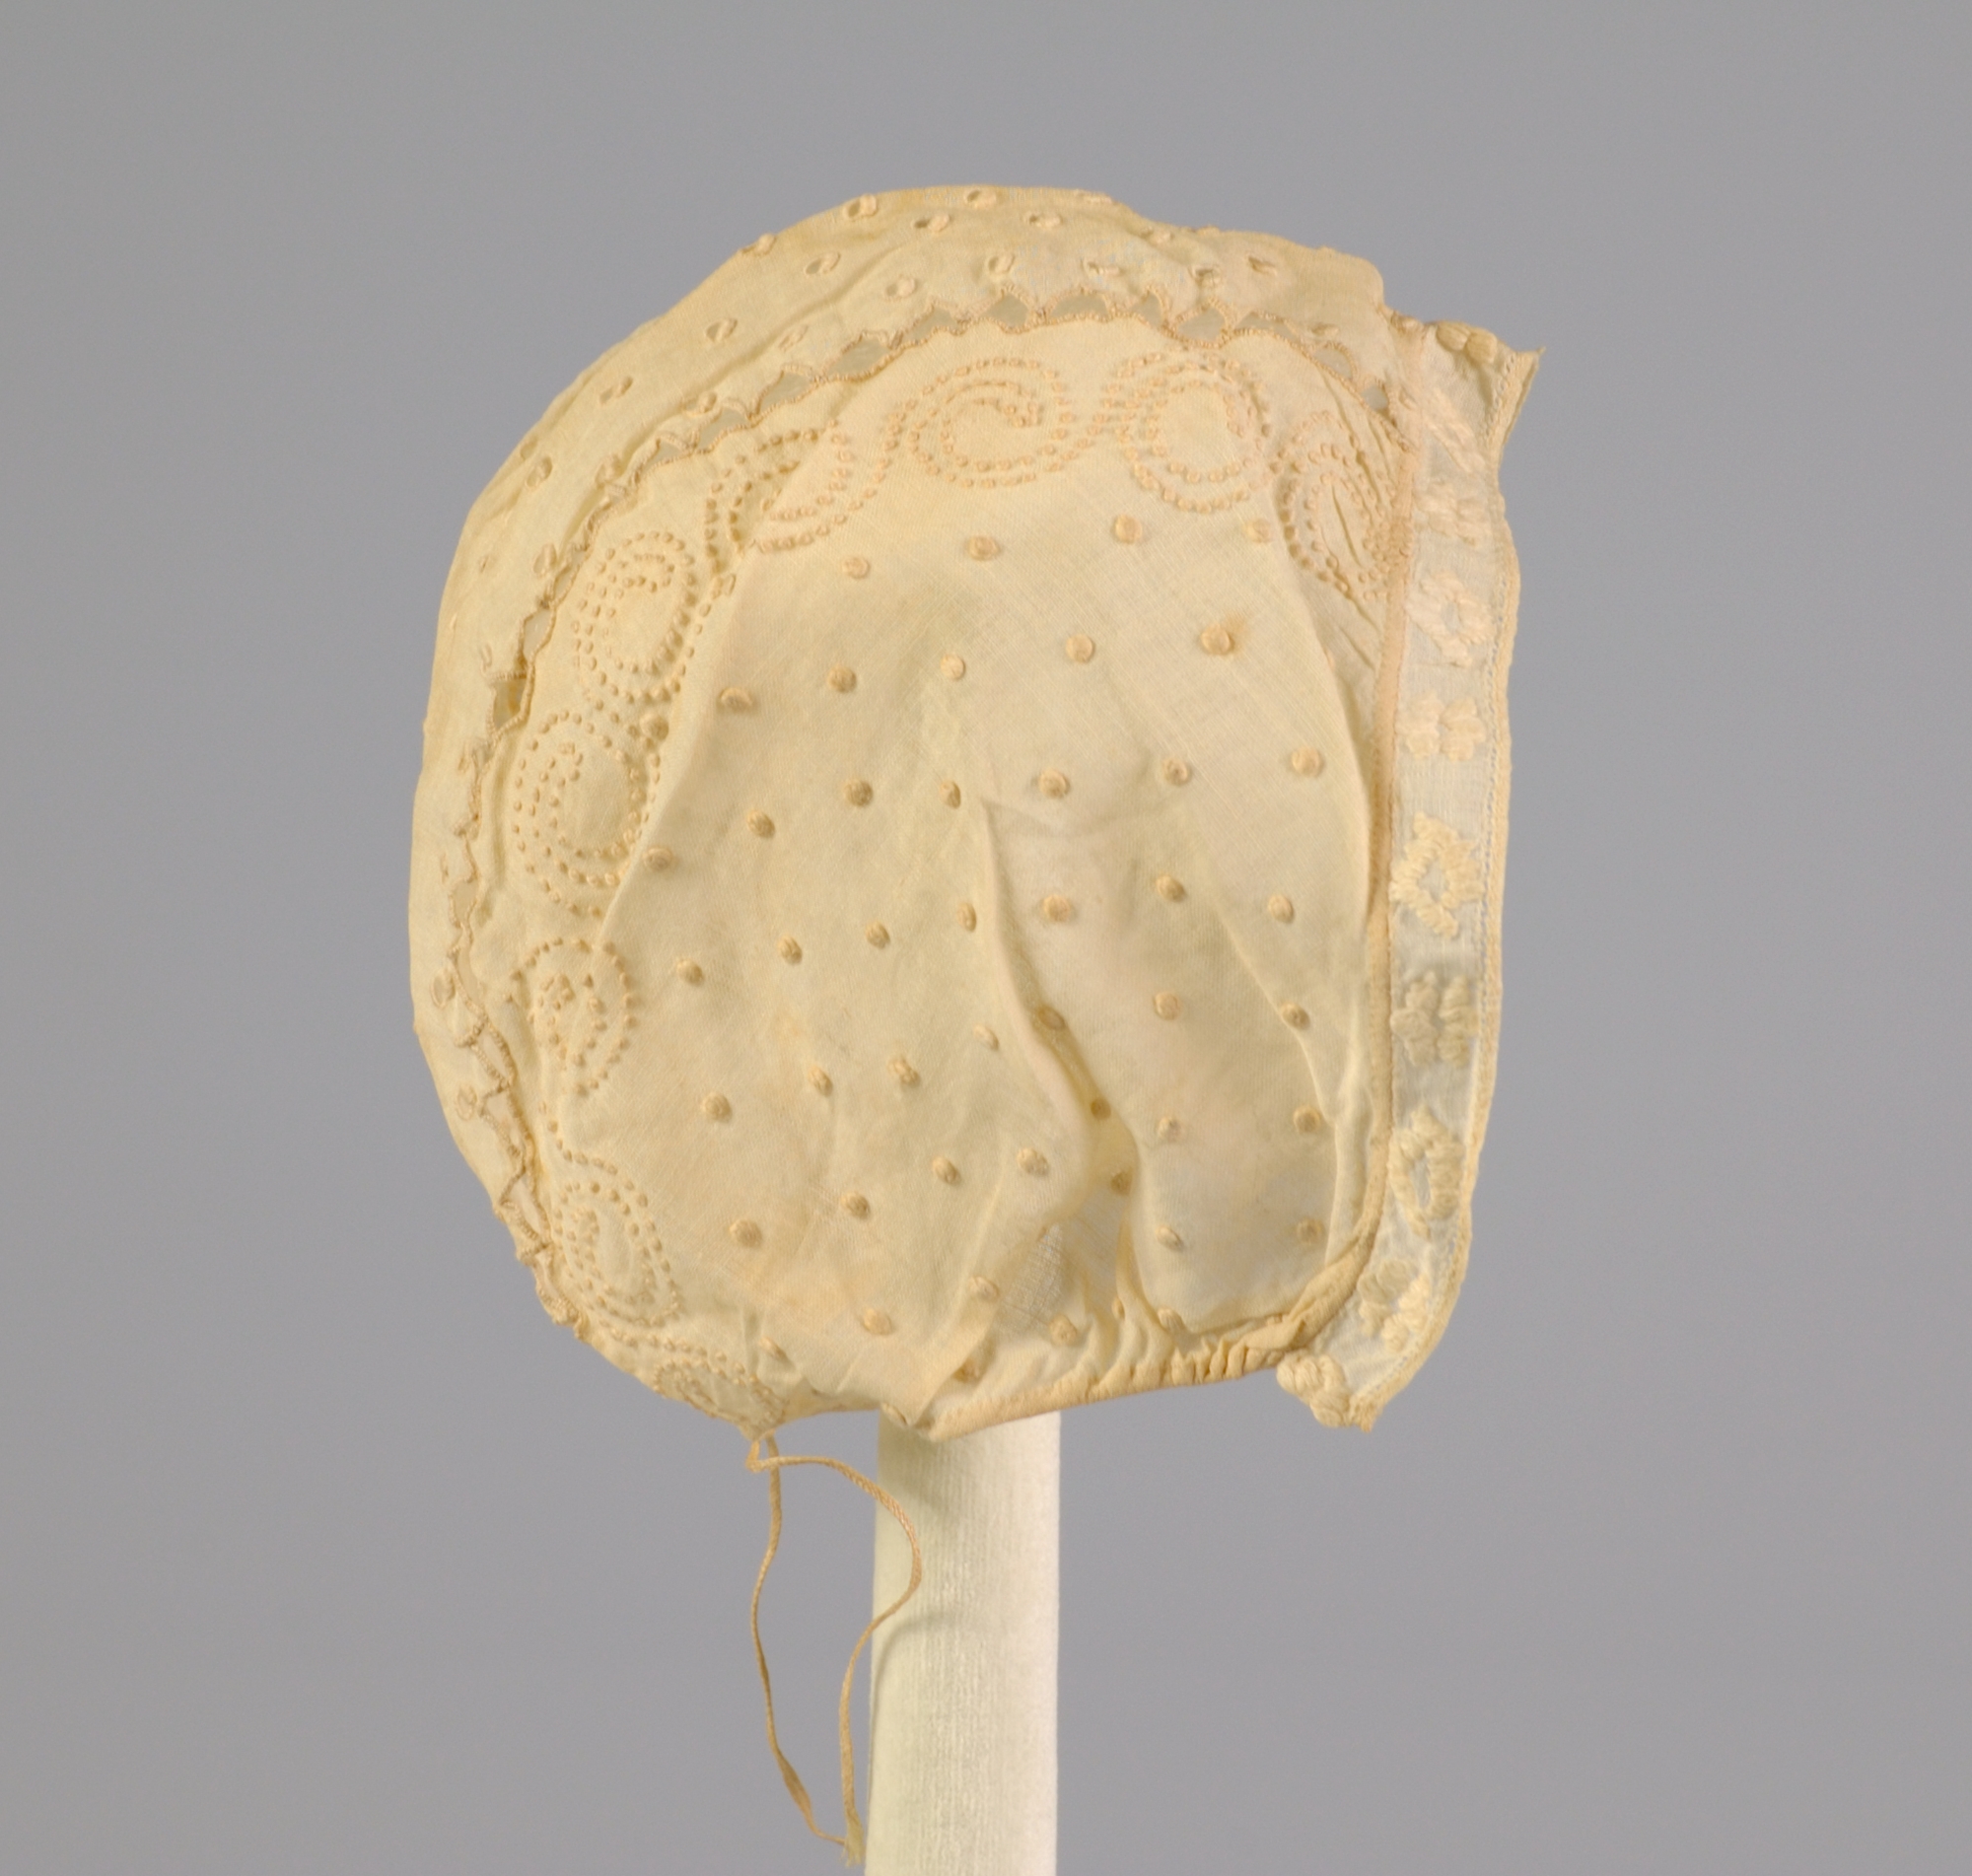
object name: cap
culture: american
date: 1820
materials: linen